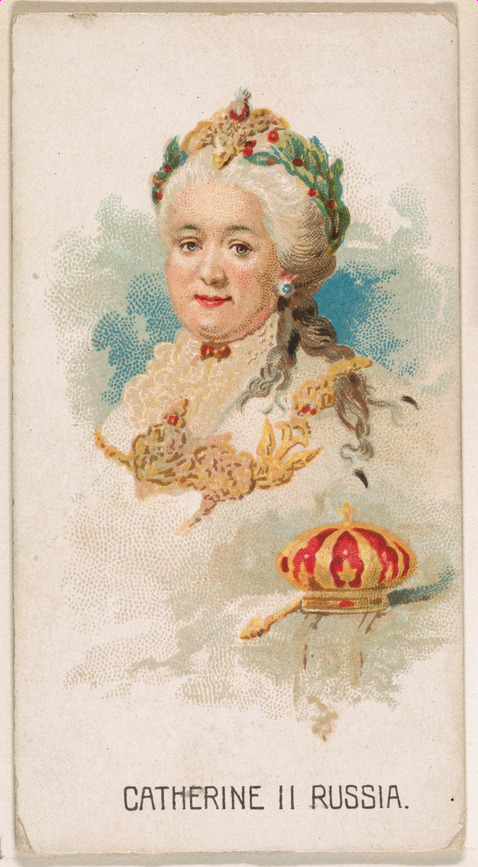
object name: print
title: Catherine II, Russia, from Leaders series (N222) issued by Kinney Bros.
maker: kinney brothers tobacco company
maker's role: publisher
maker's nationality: american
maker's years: 1869-2011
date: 1888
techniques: color lithograph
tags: women